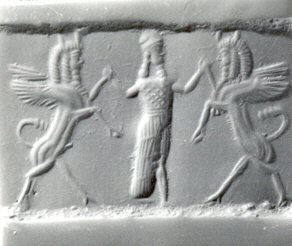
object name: cylinder seal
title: Cylinder seal with three-figure contest scene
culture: assyro-babylonian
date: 734-701 BCE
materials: stone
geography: mesopotamia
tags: animals,men